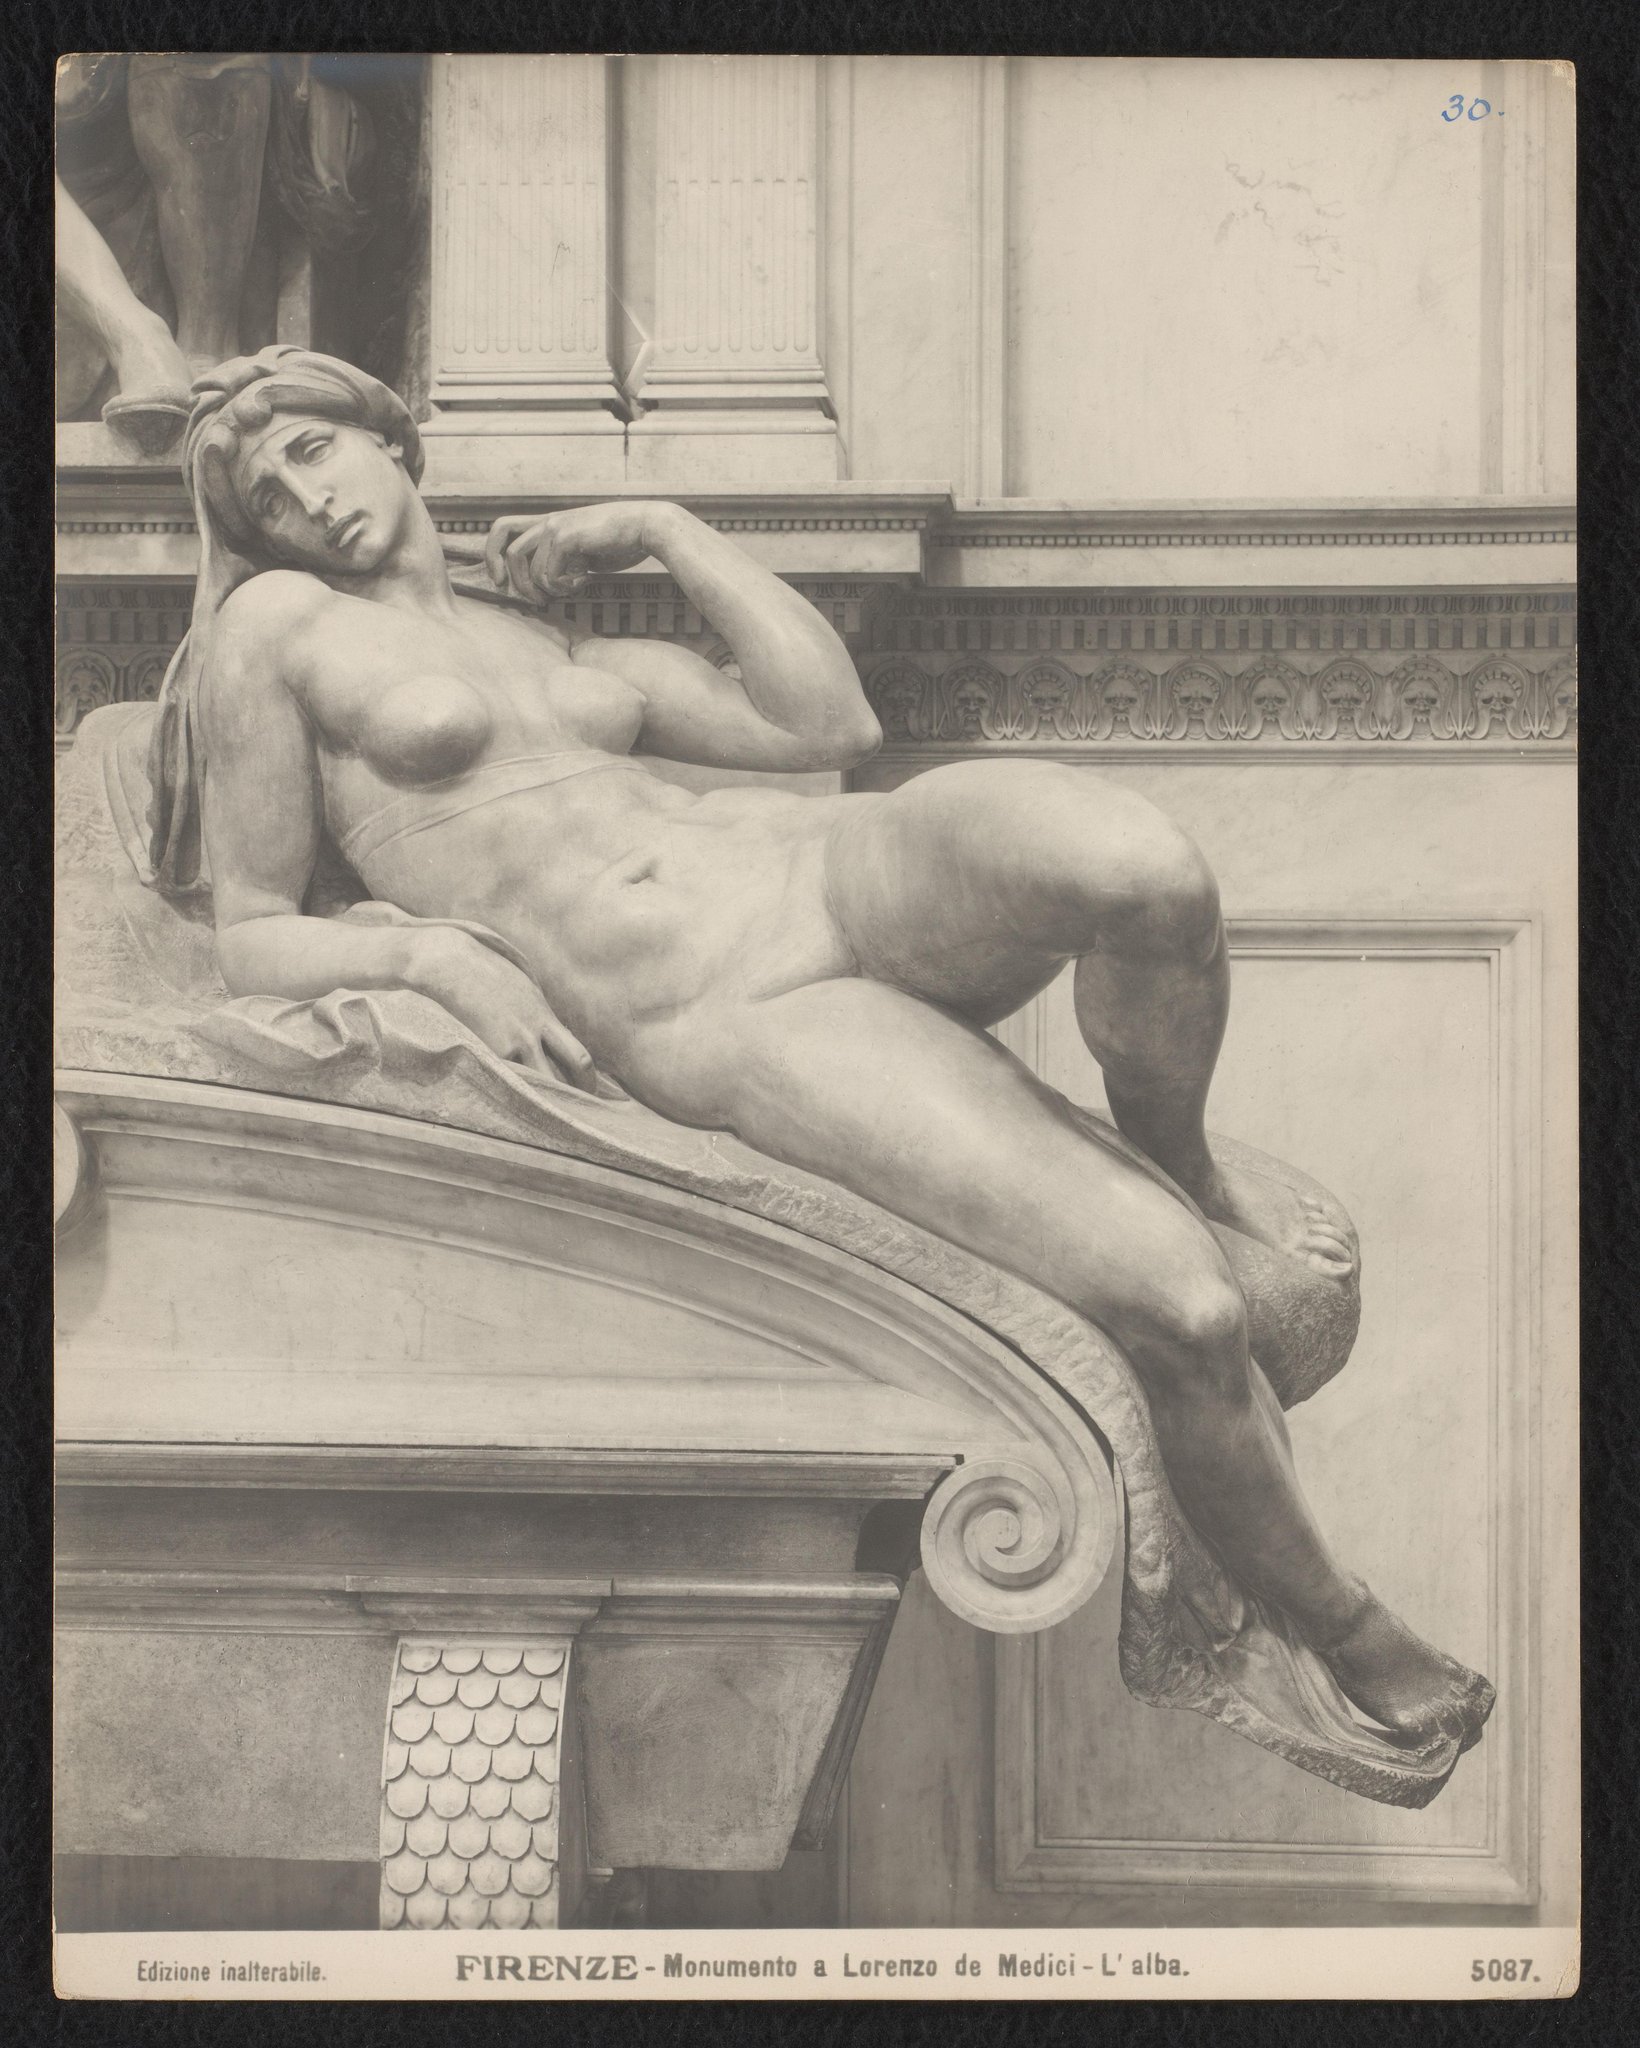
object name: photograph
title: Beeld op de graftombe van Lorenzo de'Medici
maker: Anonymous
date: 1900-1920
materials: paper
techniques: gelatin silver print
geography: florence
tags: lorenzo de' medici, grave-building, monumental tomb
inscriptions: number: ‘5087.’, inscription: ‘Edizione inalterabile.’, number: ‘30.’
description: Deze foto maakt deel uit van een omslag.